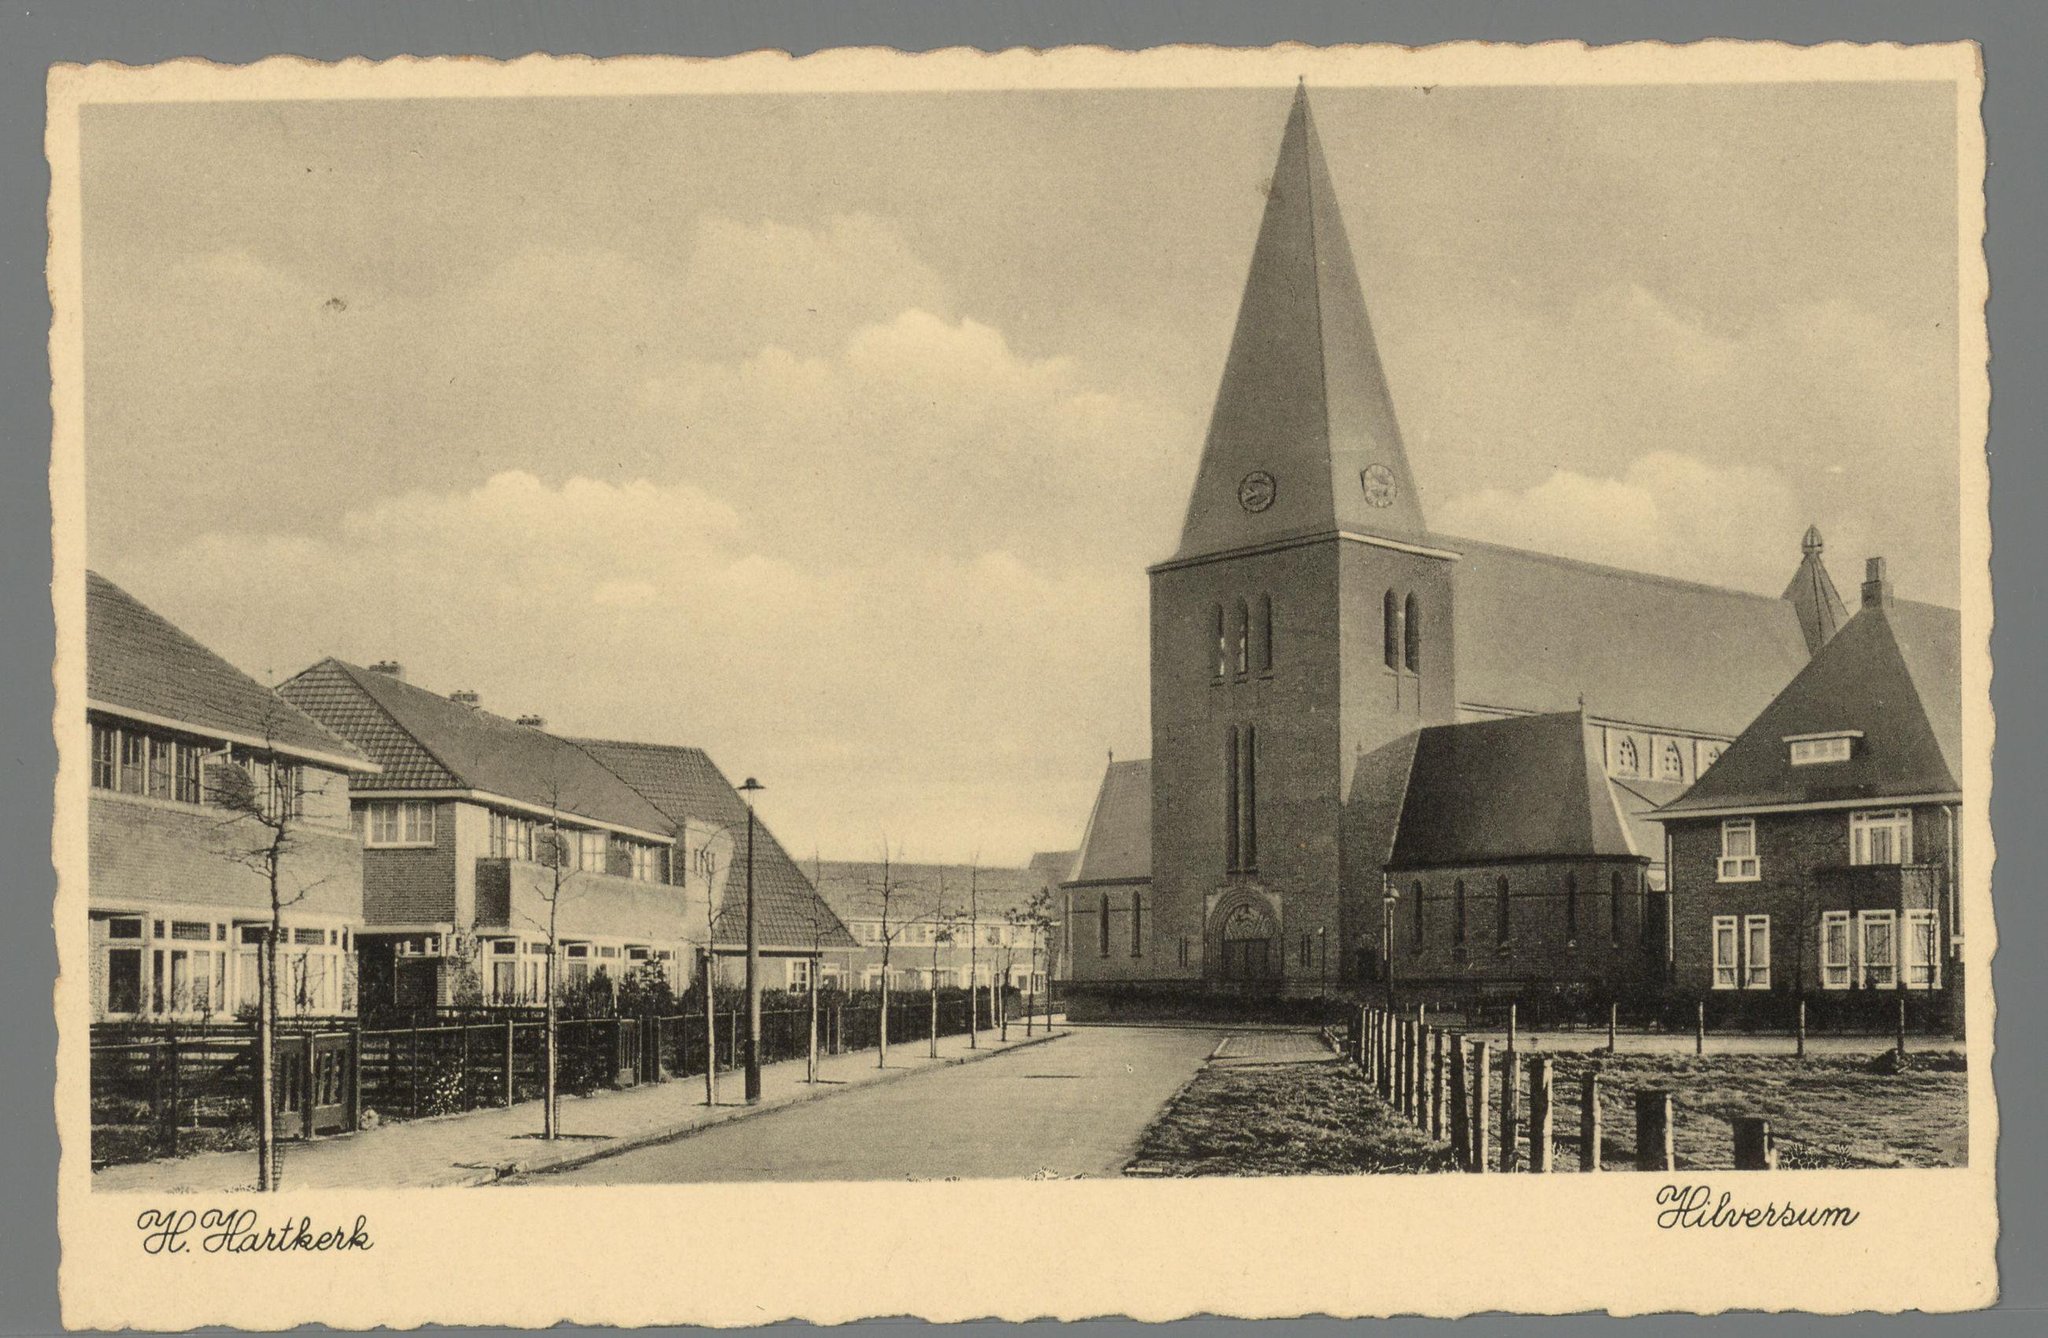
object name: ansichtkaart, prentbriefkaart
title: H. Hartkerk Hilversum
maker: Anonymous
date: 1928-1950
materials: cardboard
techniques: photograph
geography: hilversum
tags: city-view, and landscape with man-made constructions, church (exterior)